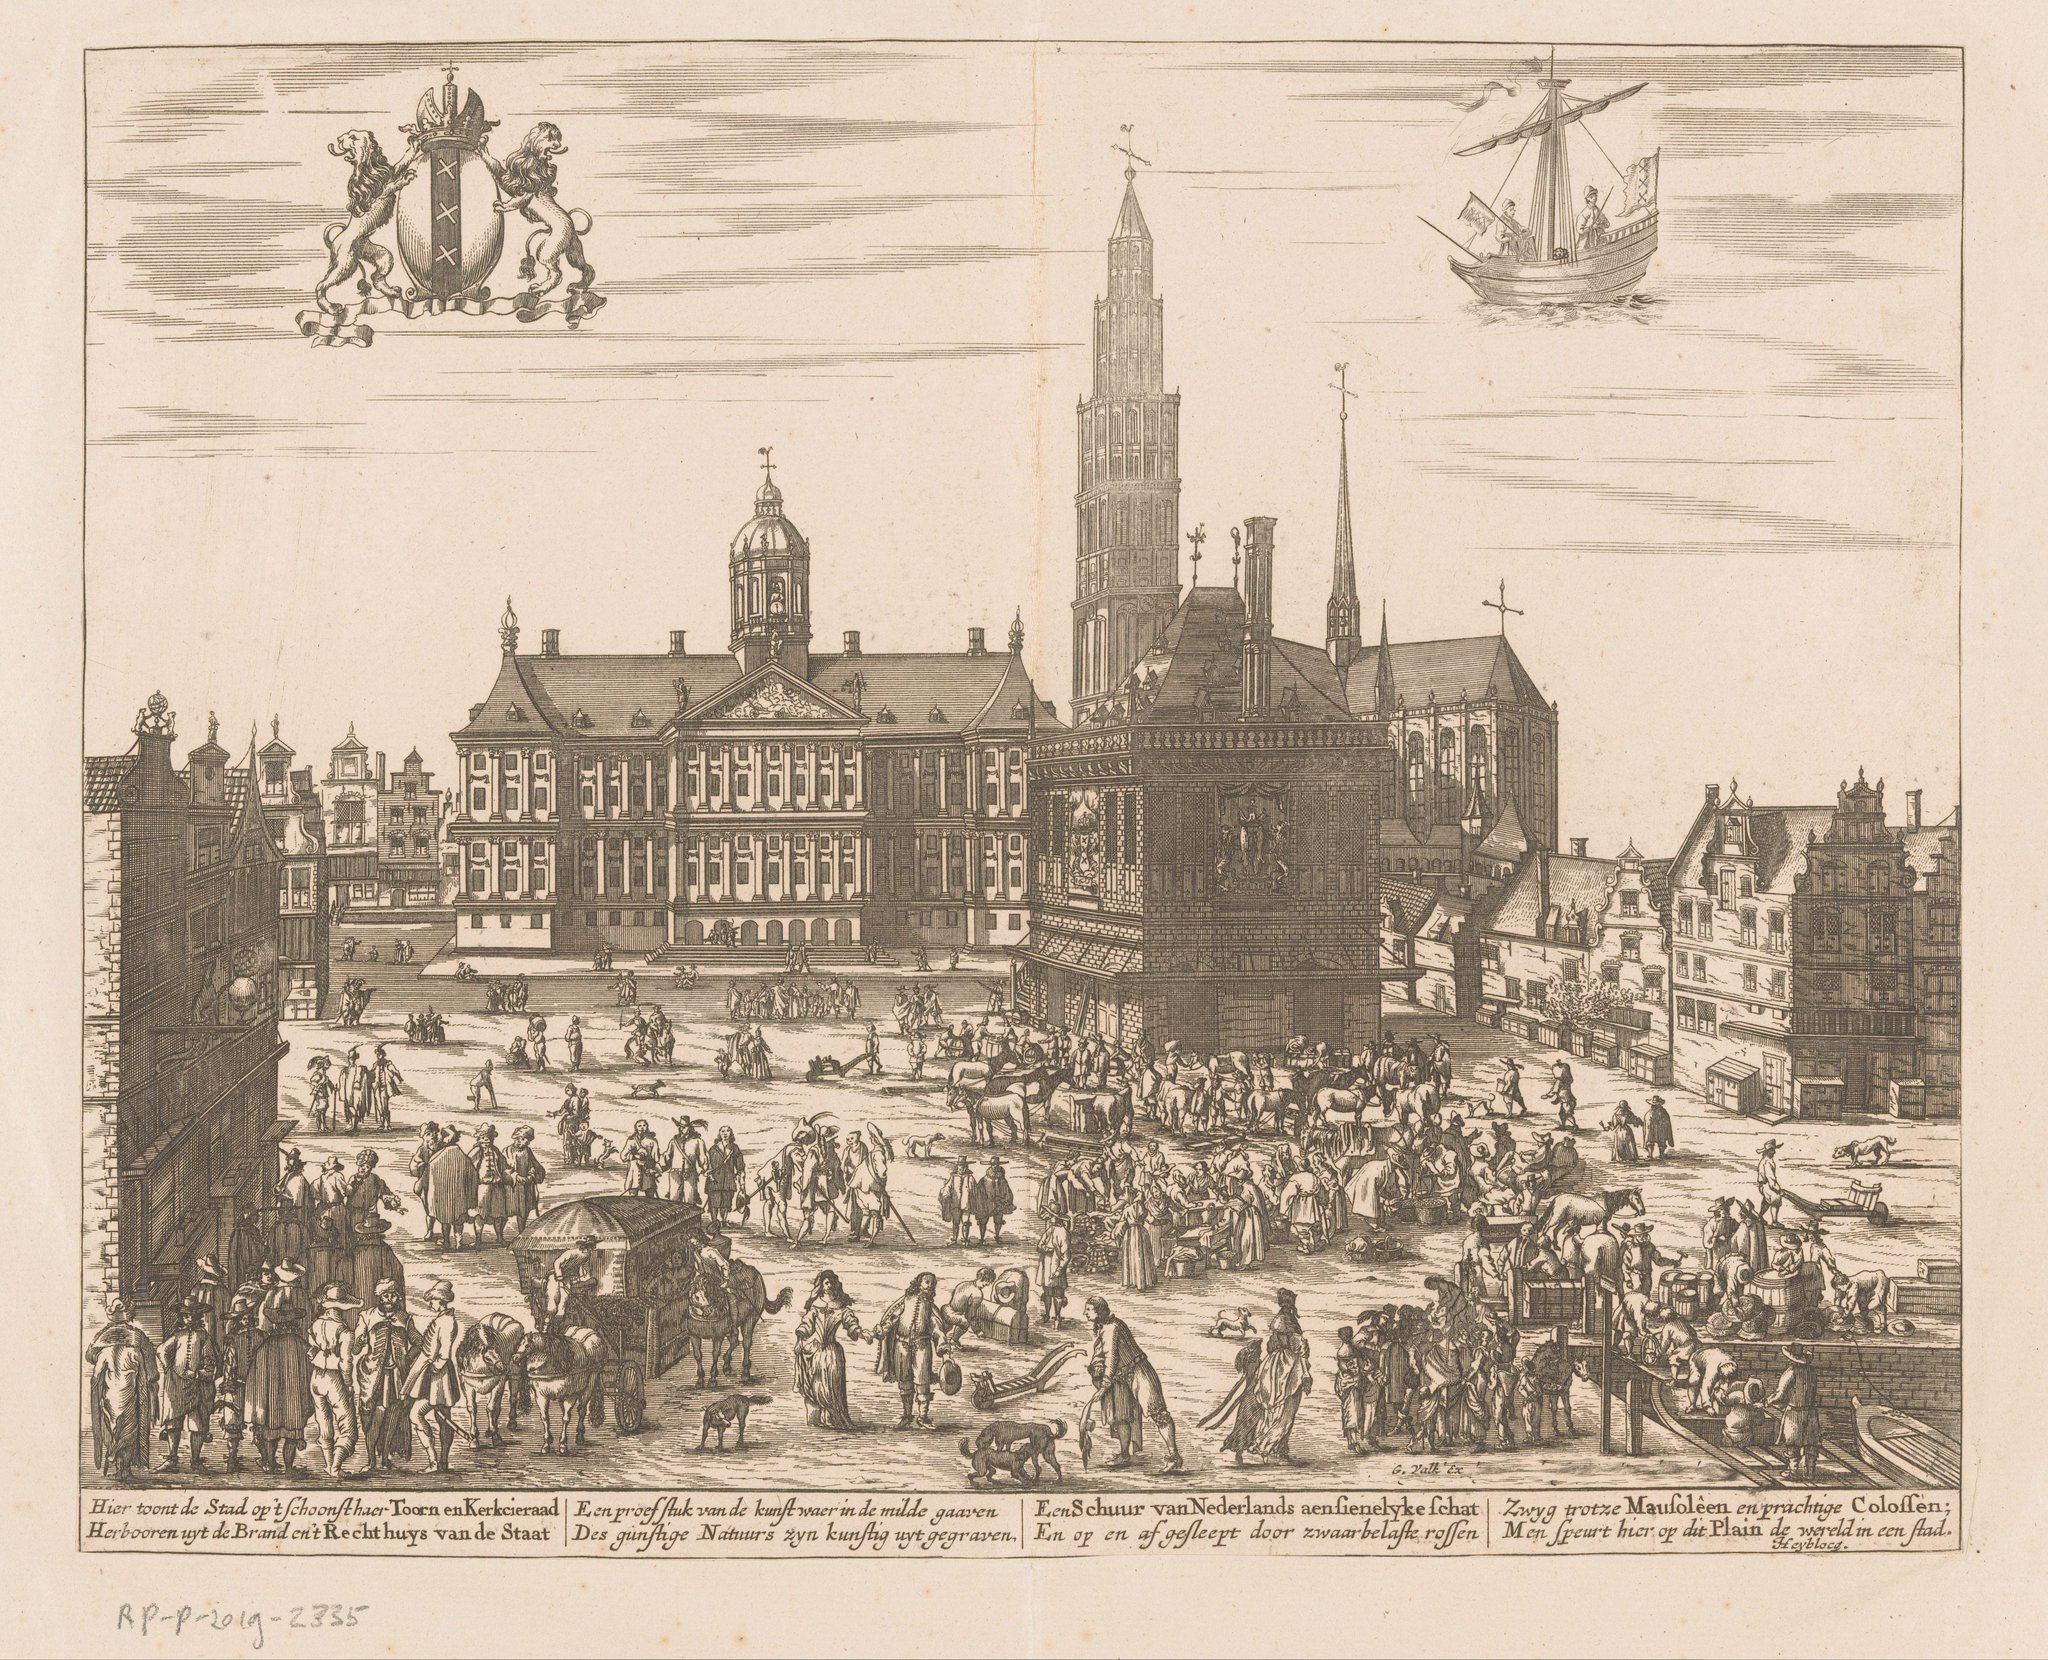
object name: print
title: Gezicht op het Stadhuis, de Nieuwe Kerk en de Waag op de Dam te Amsterdam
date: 1670-1726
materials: paper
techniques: etching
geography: amsterdam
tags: church (exterior), townhall, weigh-house, square, place, circus, etc. (+ city(-scape) with figures, staffage)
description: Onder de prent een achtregelig Nederlands vers.